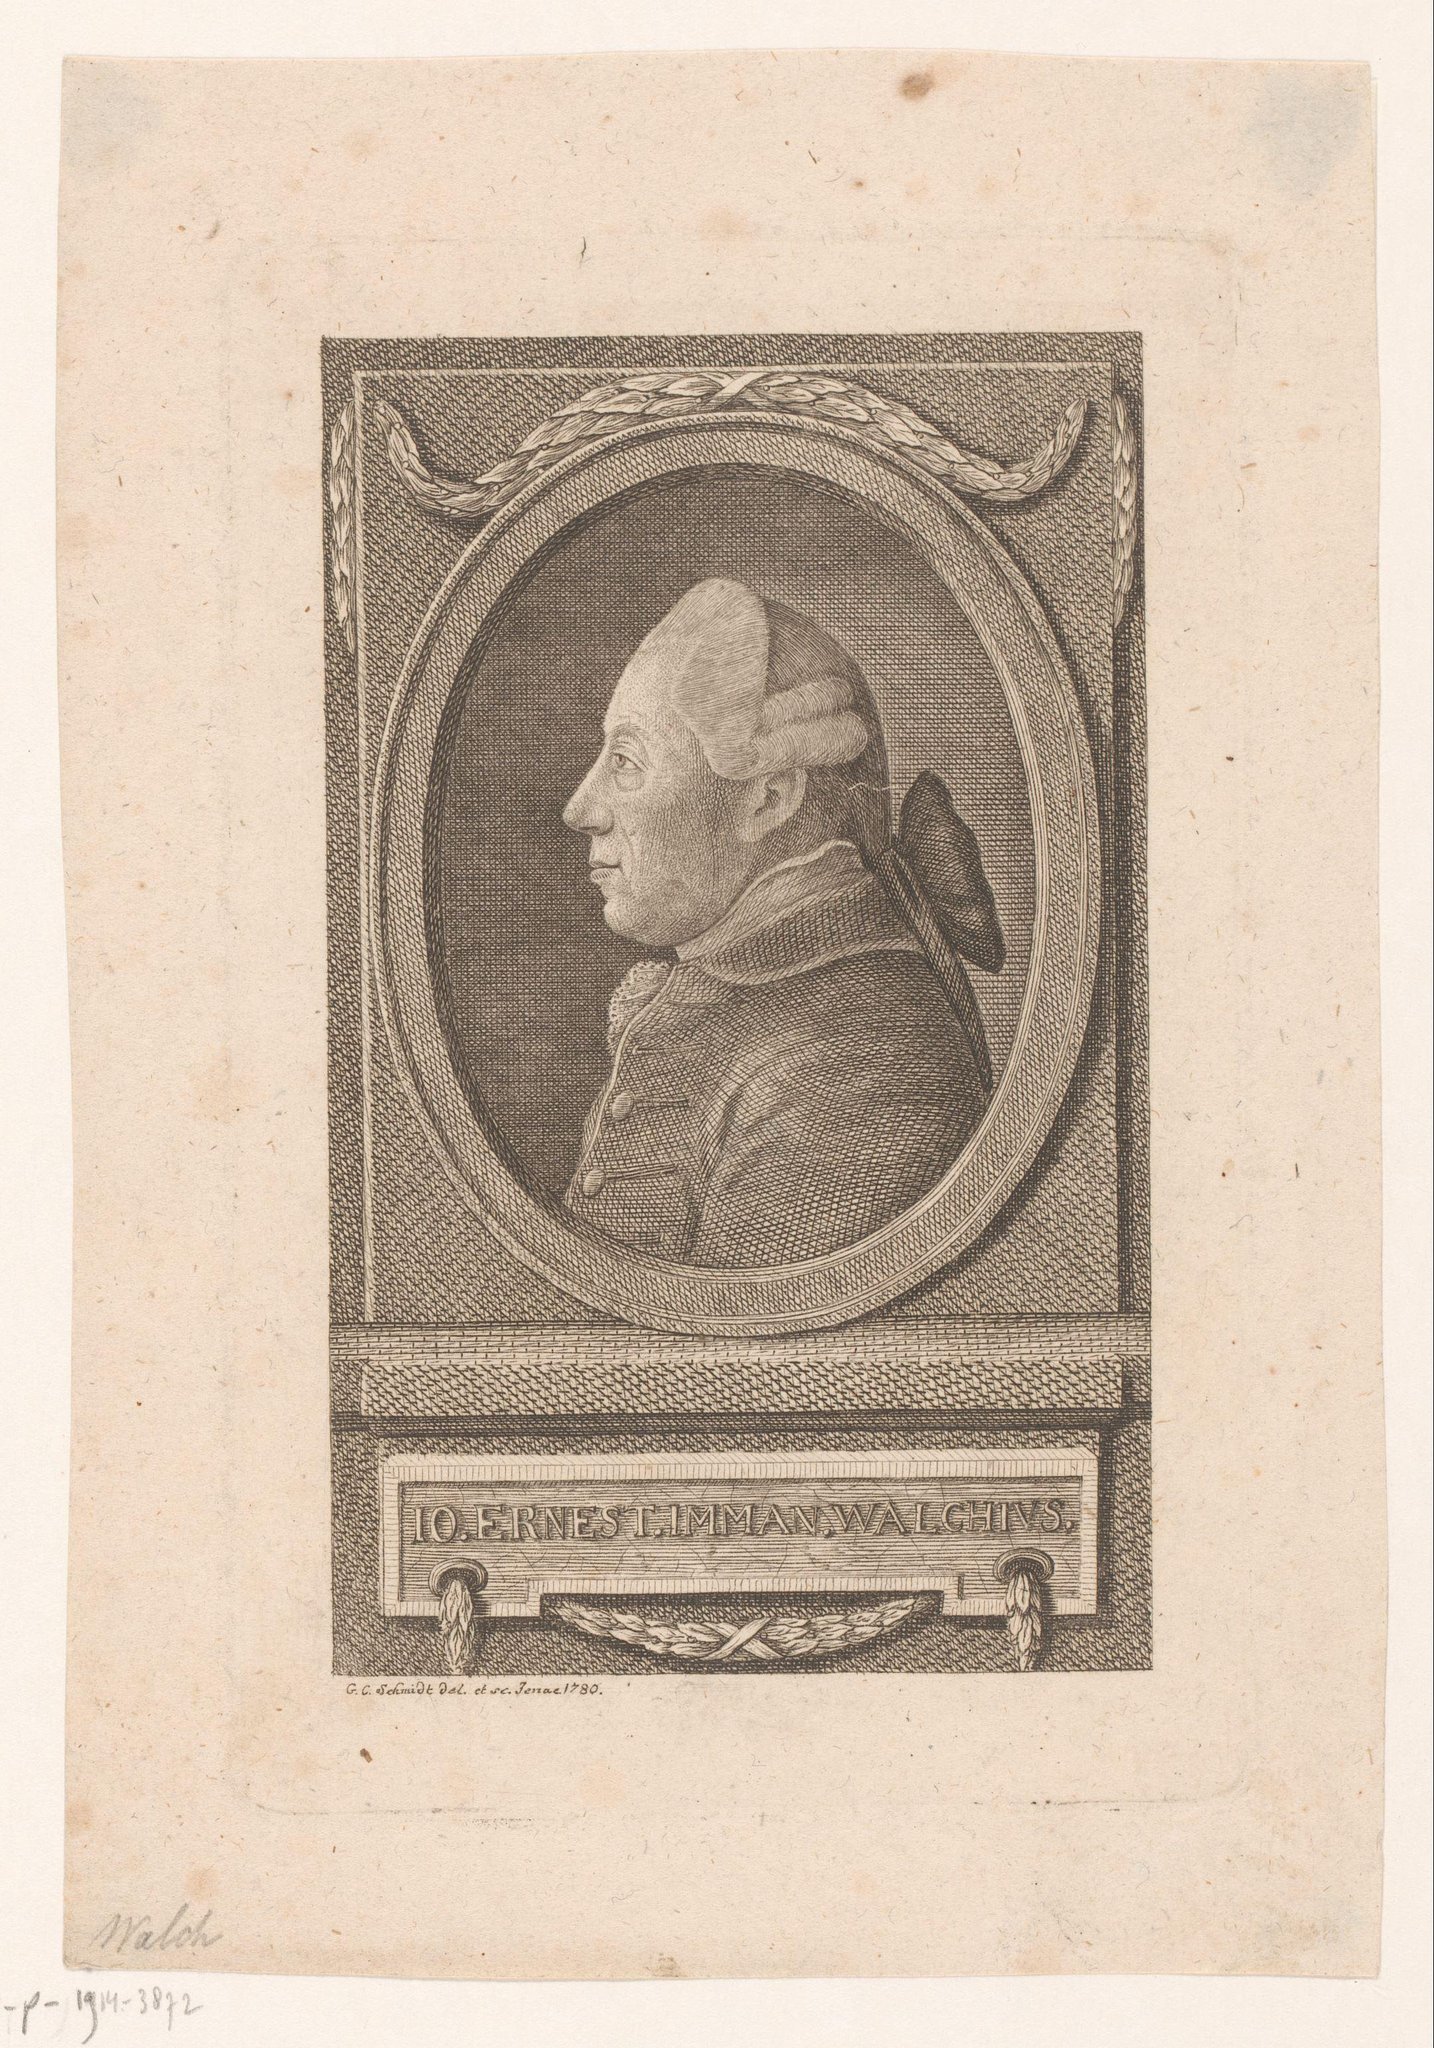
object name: print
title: Portret van Johann Ernst Immanuel Walch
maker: georg christoph schmidt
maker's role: print maker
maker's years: 1740-1811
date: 1780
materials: paper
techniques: etching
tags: historical persons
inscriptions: collector's mark: Lugt 2228